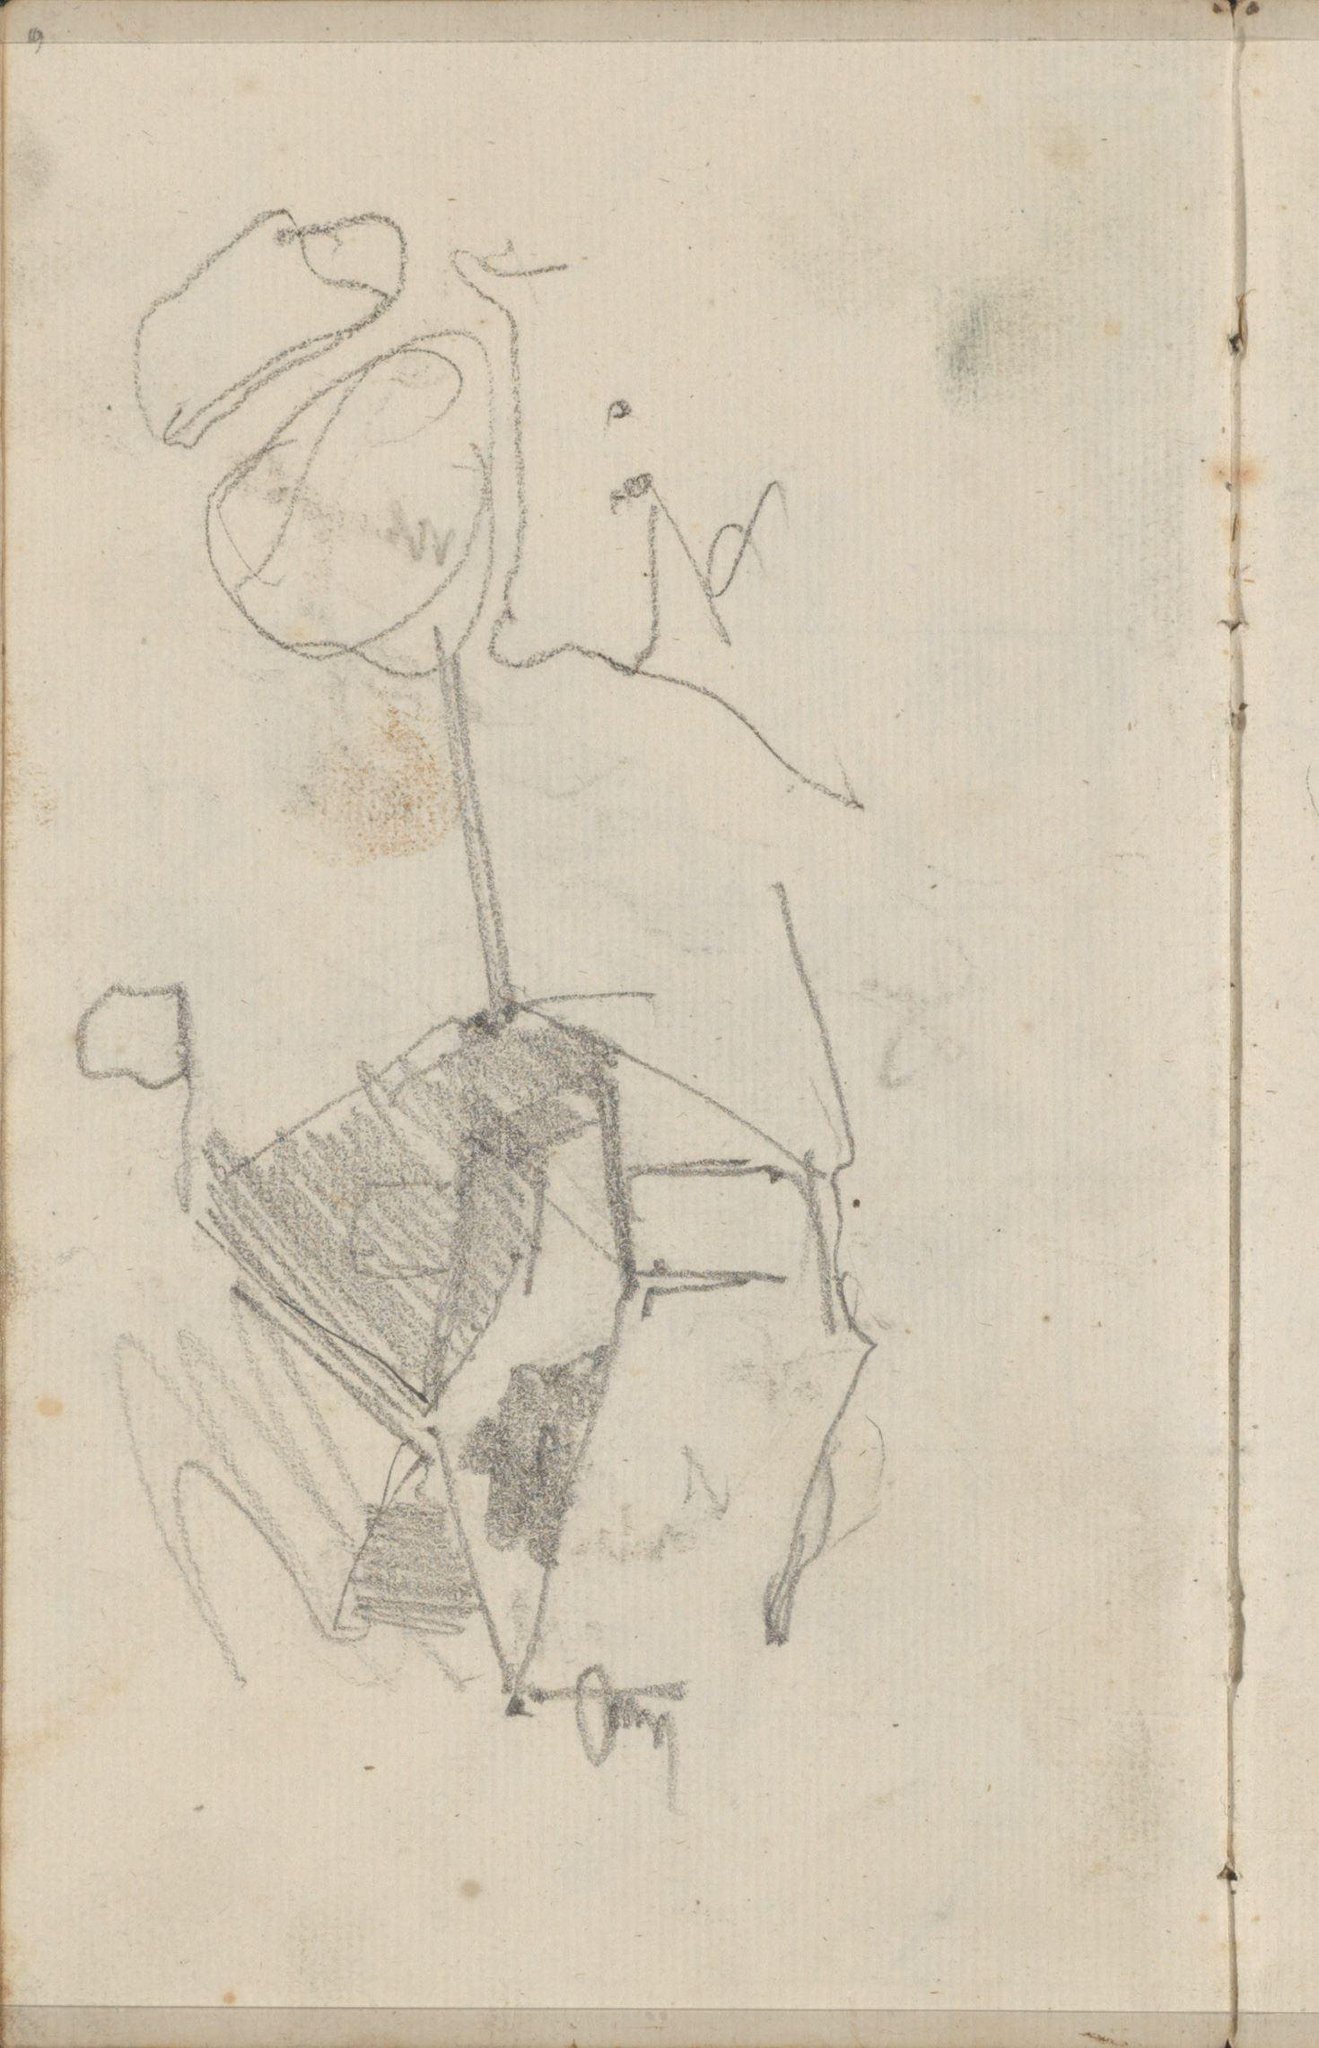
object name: sketchbook leaf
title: Gebouw in Scheveningen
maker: george hendrik breitner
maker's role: draughtsman, painter, print maker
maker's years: 1857-1923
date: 1880-1882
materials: paper, pencil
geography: scheveningen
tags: architecture, civic architecture; edifices; dwellings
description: Pagina 19 uit een schetsboek met 31 bladen.